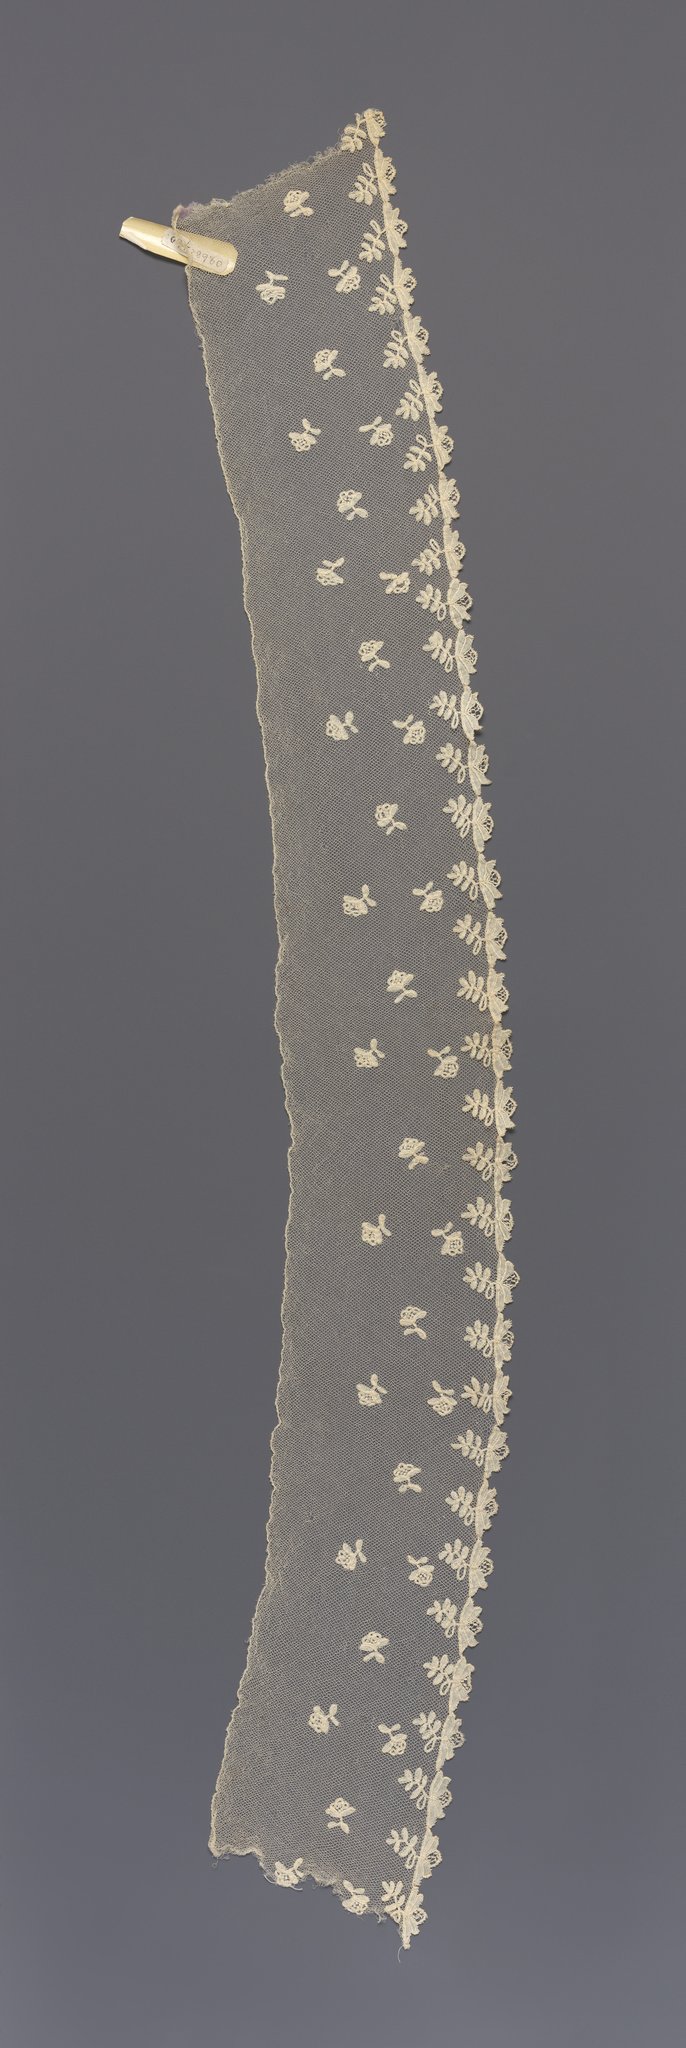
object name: piece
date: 1801-1900